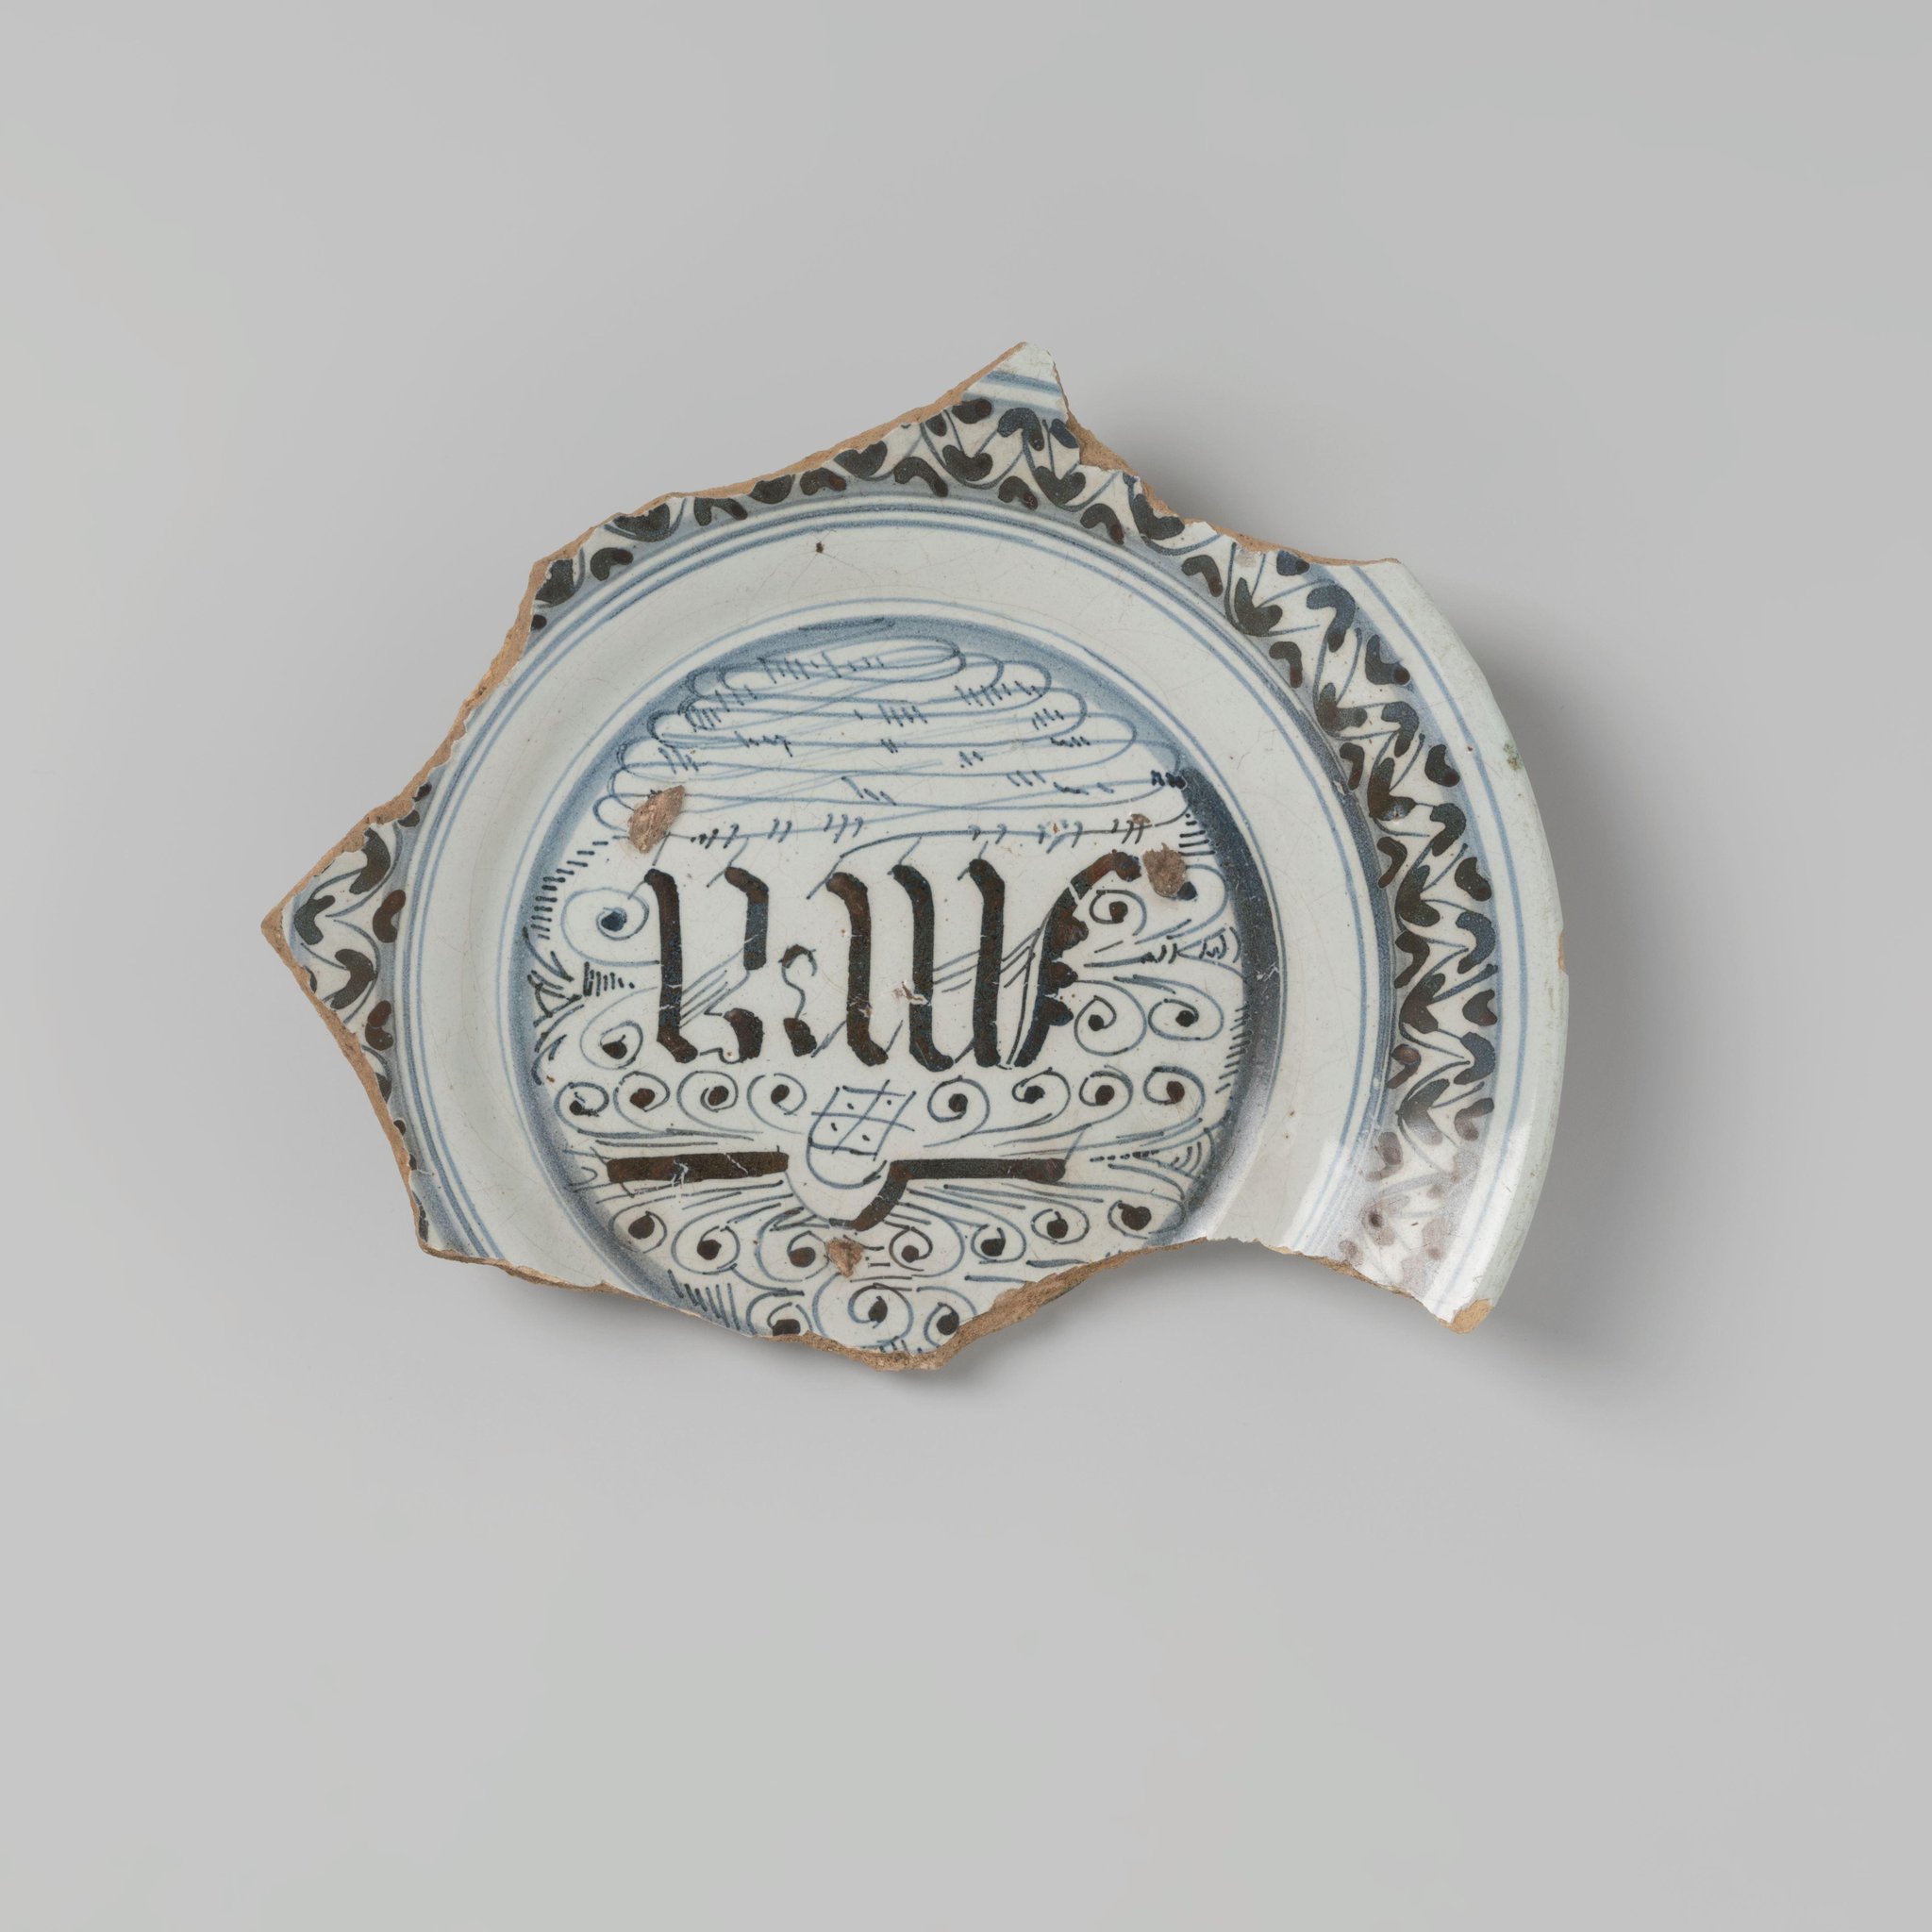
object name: plate dish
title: Bord van aardewerk, voorzien van loodglazuur aan de onderzijde en wit tinglazuur aan de bovenzijde, en in blauw onder andere de letters omega M A, beschadigd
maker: Anonymous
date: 1500-1799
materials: earthenware, glaze